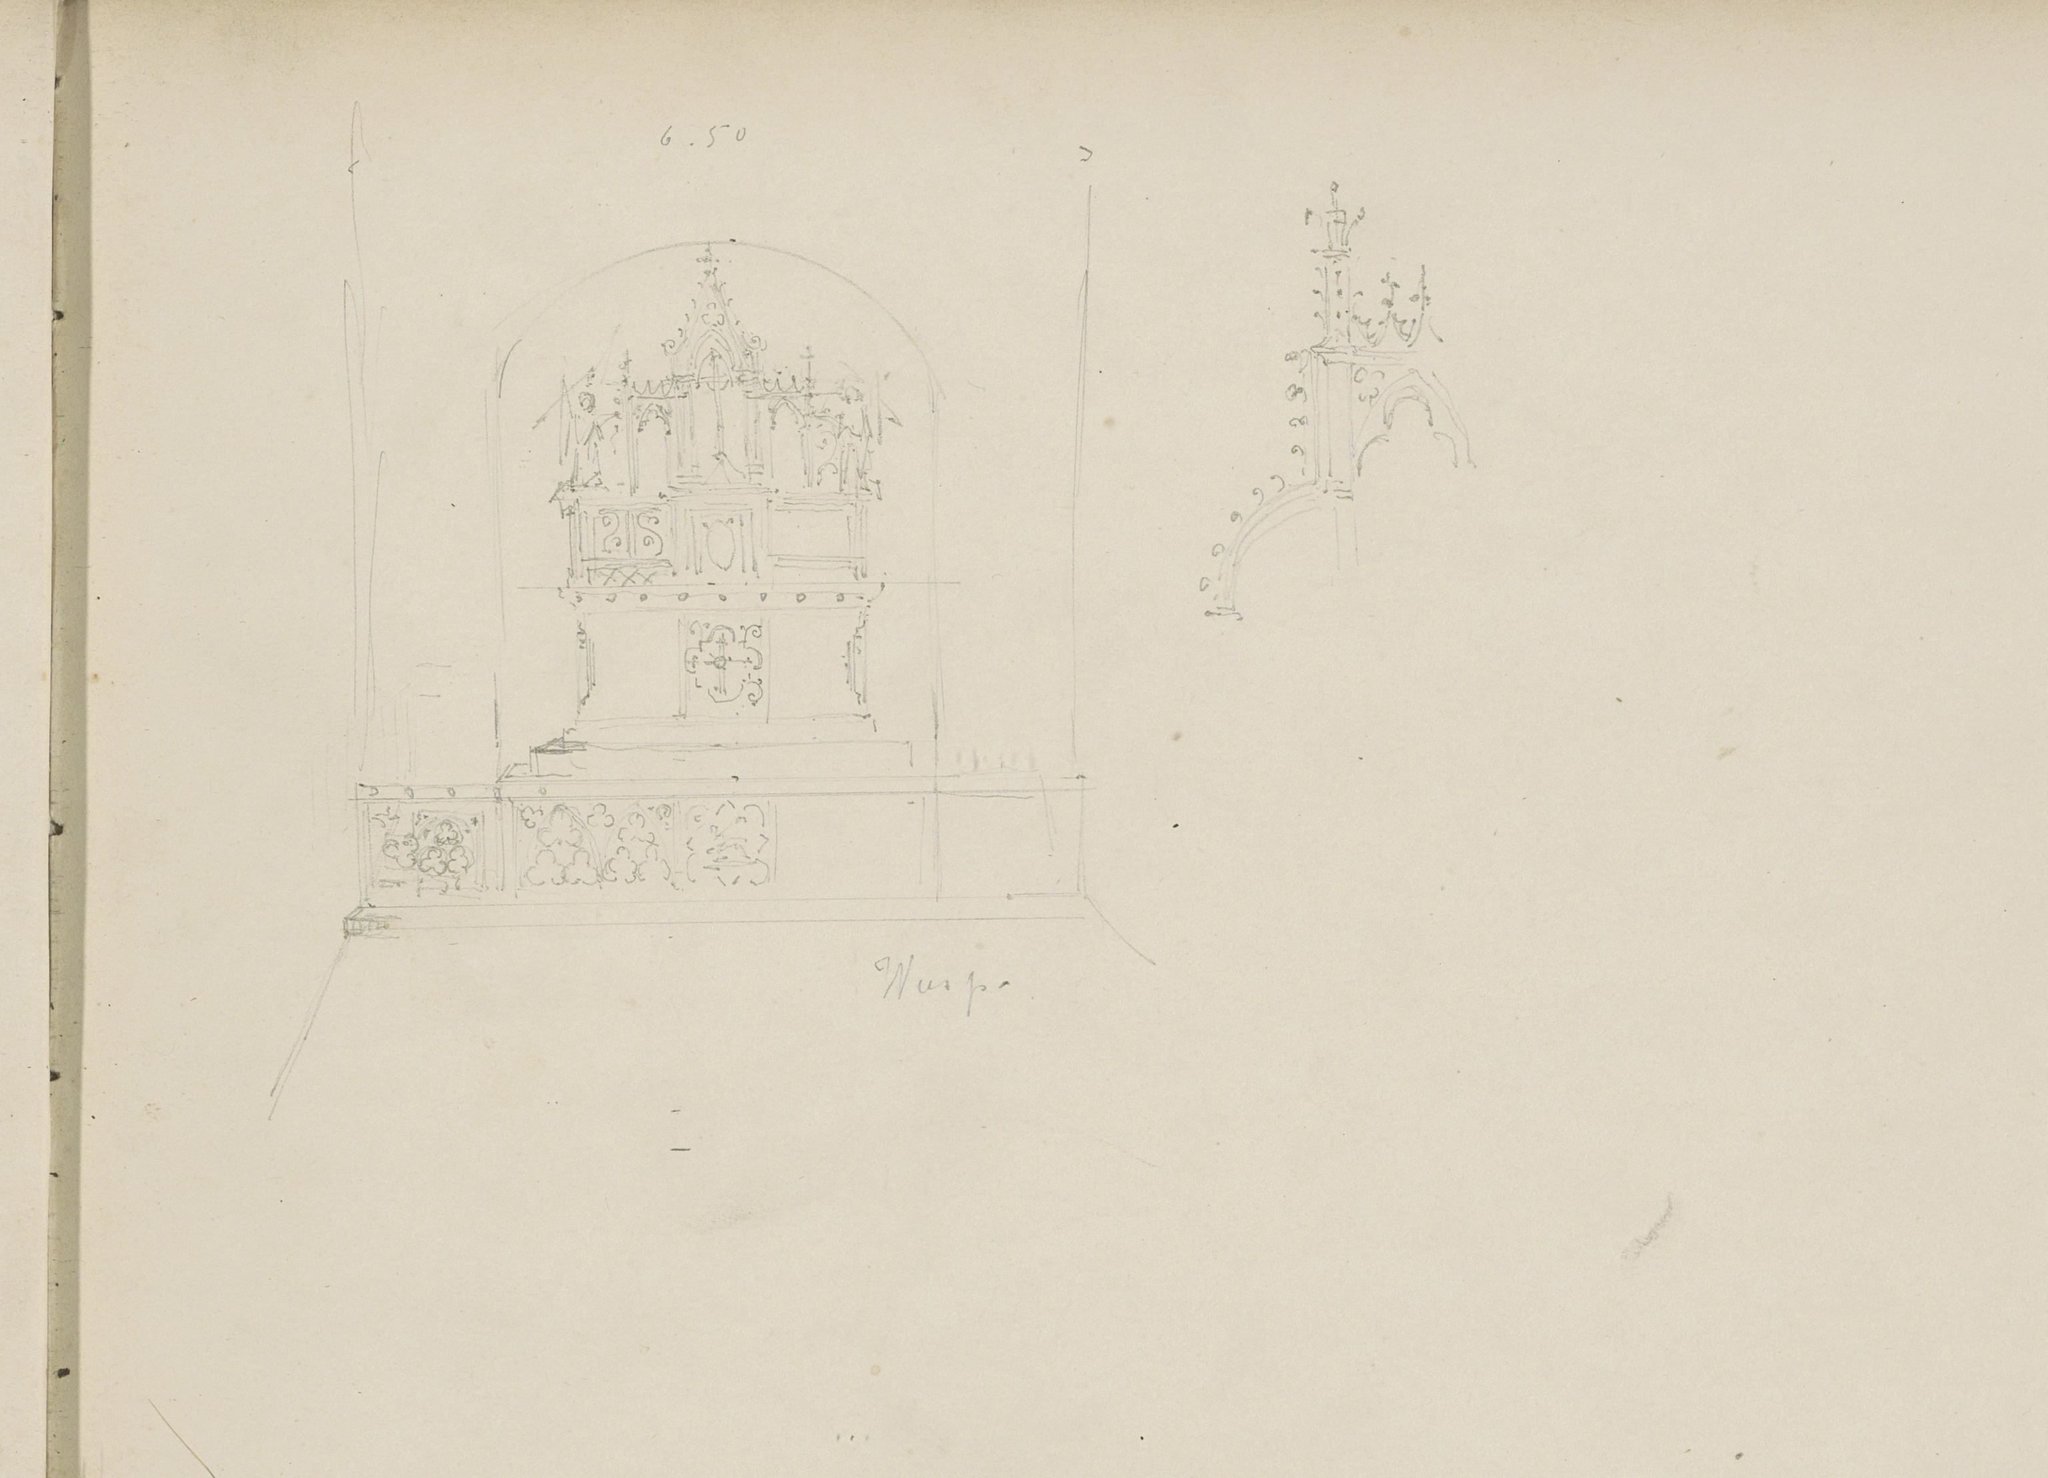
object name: sketchbook leaf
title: Altaar, Weesp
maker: pierre joseph hubert cuypers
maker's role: draughtsman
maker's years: 1827-1921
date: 1857-1859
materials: paper, pencil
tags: altar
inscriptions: annotation: ‘6.50/ Weesp’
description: Titel gebaseerd op annotatie en inhoudsopgave door Cuypers op blad 77 recto.